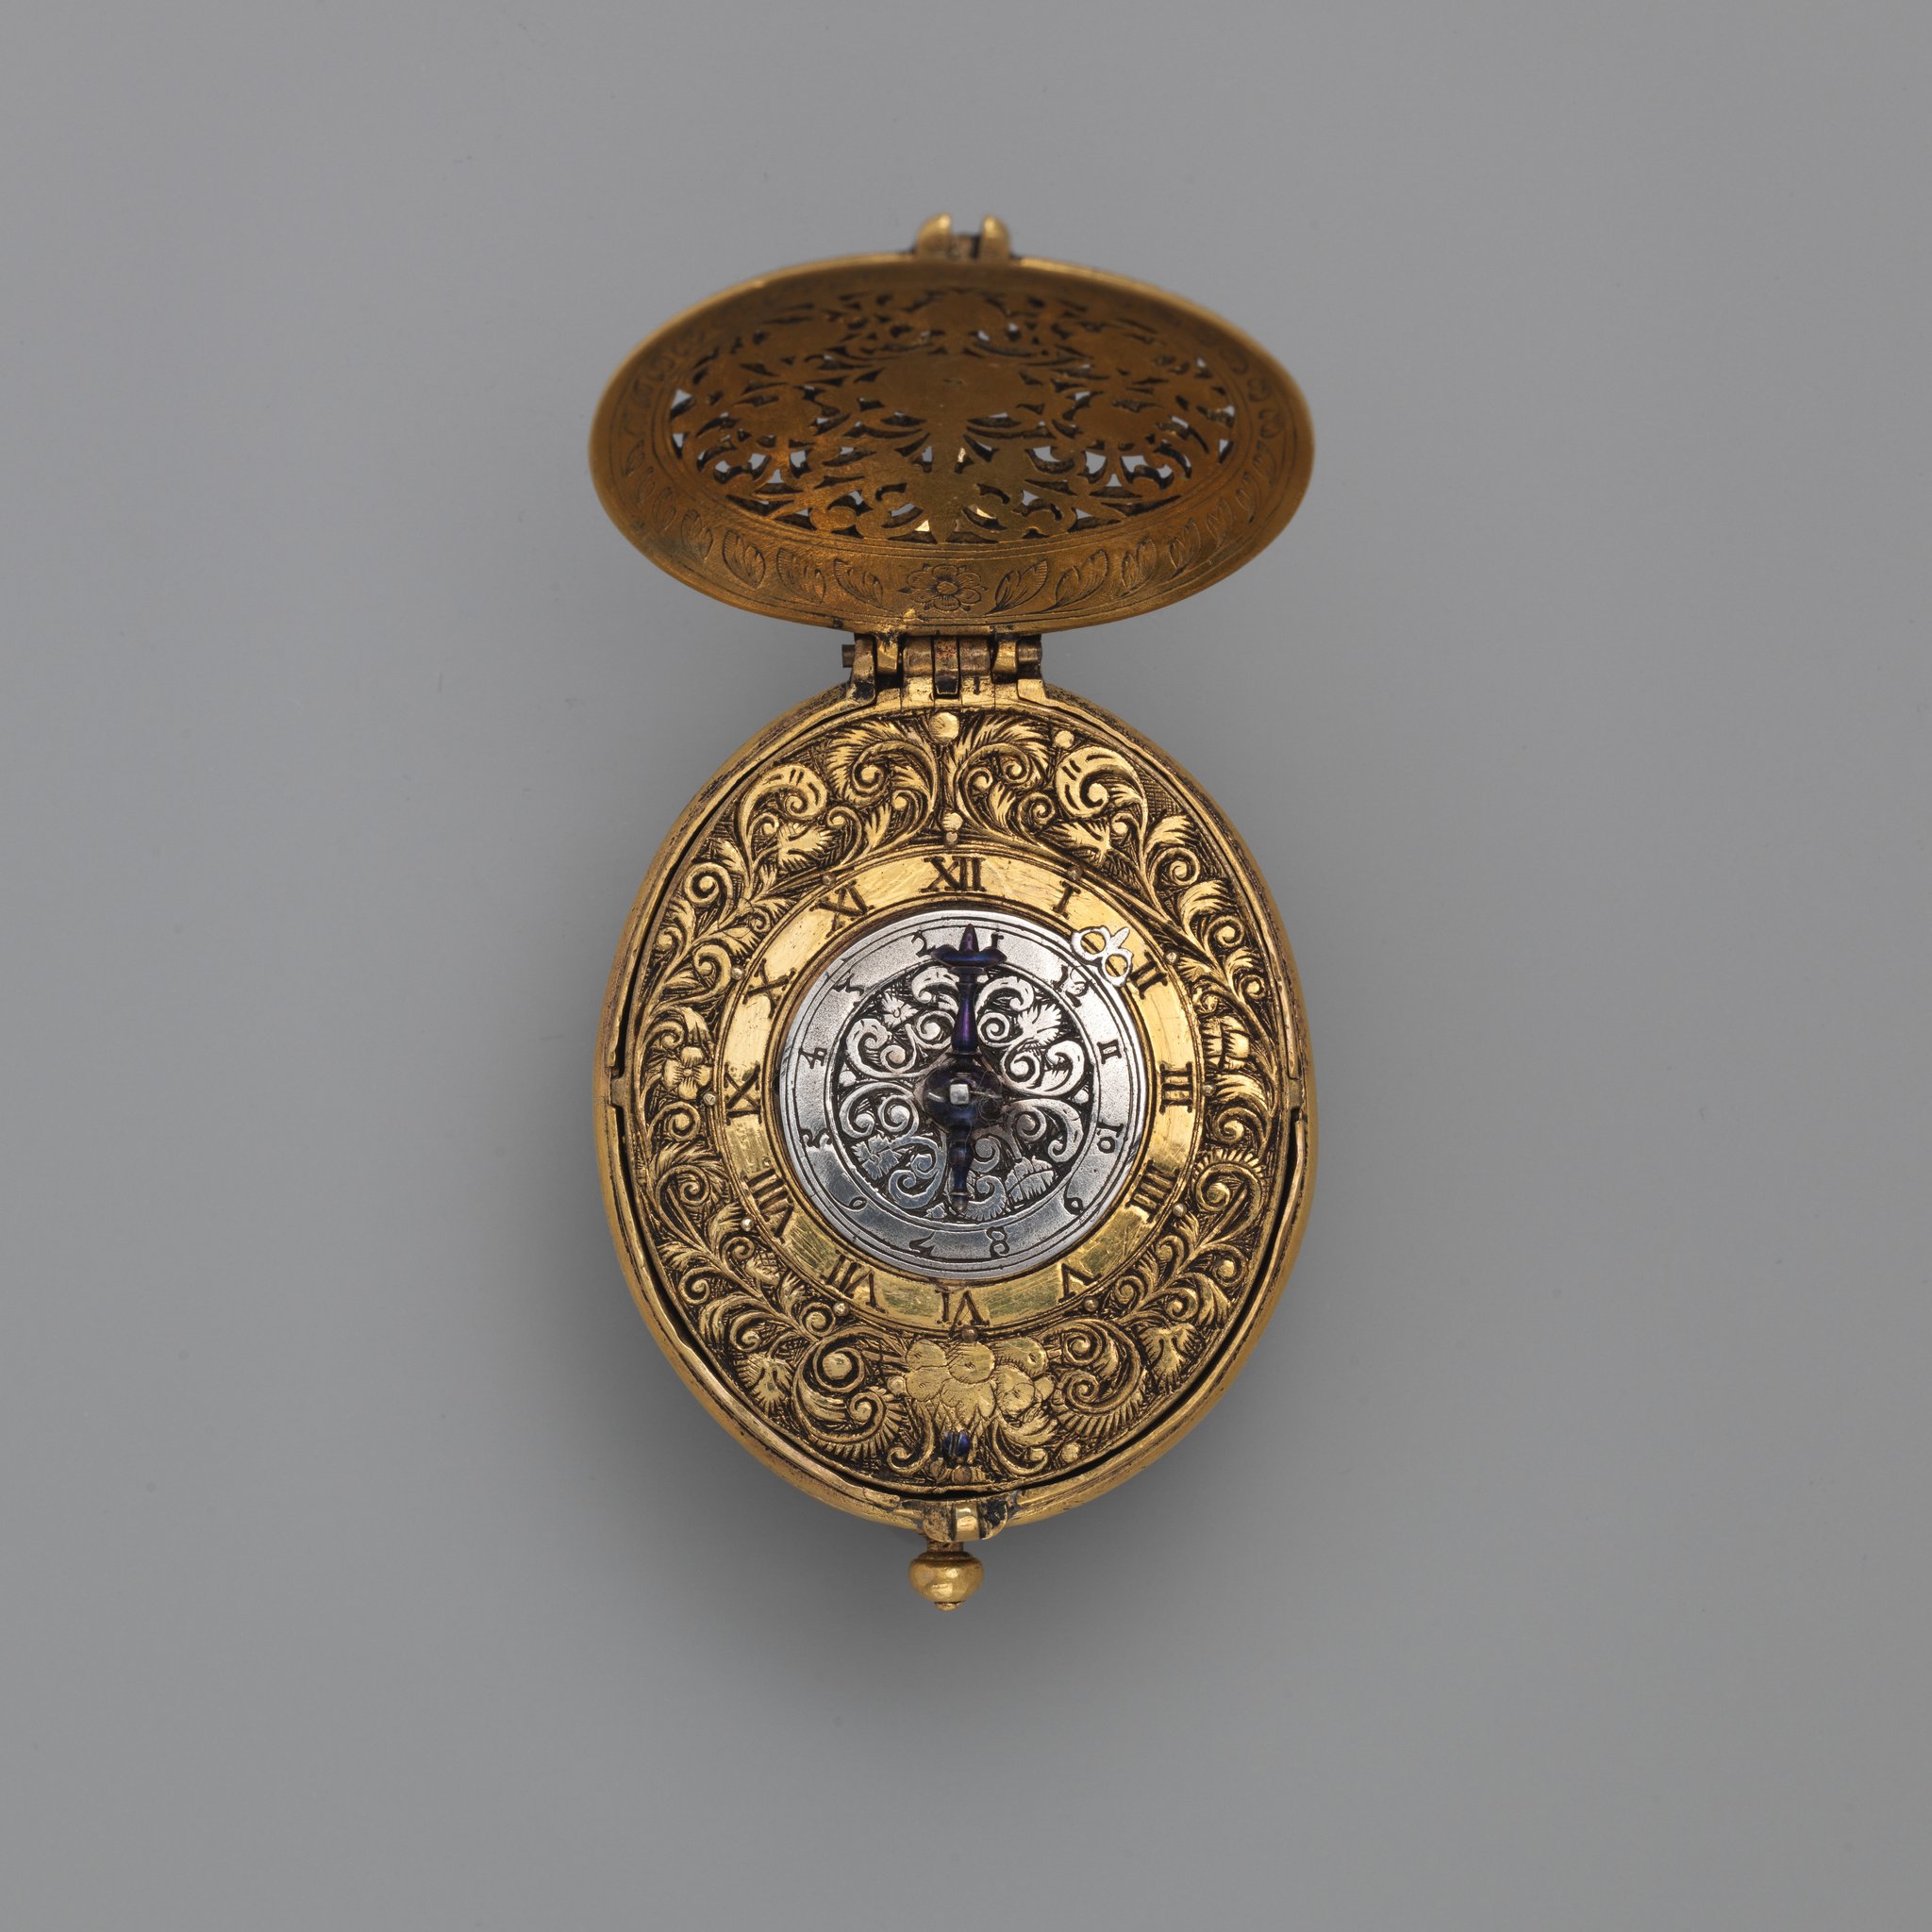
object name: watch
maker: edward east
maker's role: maker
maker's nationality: british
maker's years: 1602-1697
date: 1801-1900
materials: silver gilt